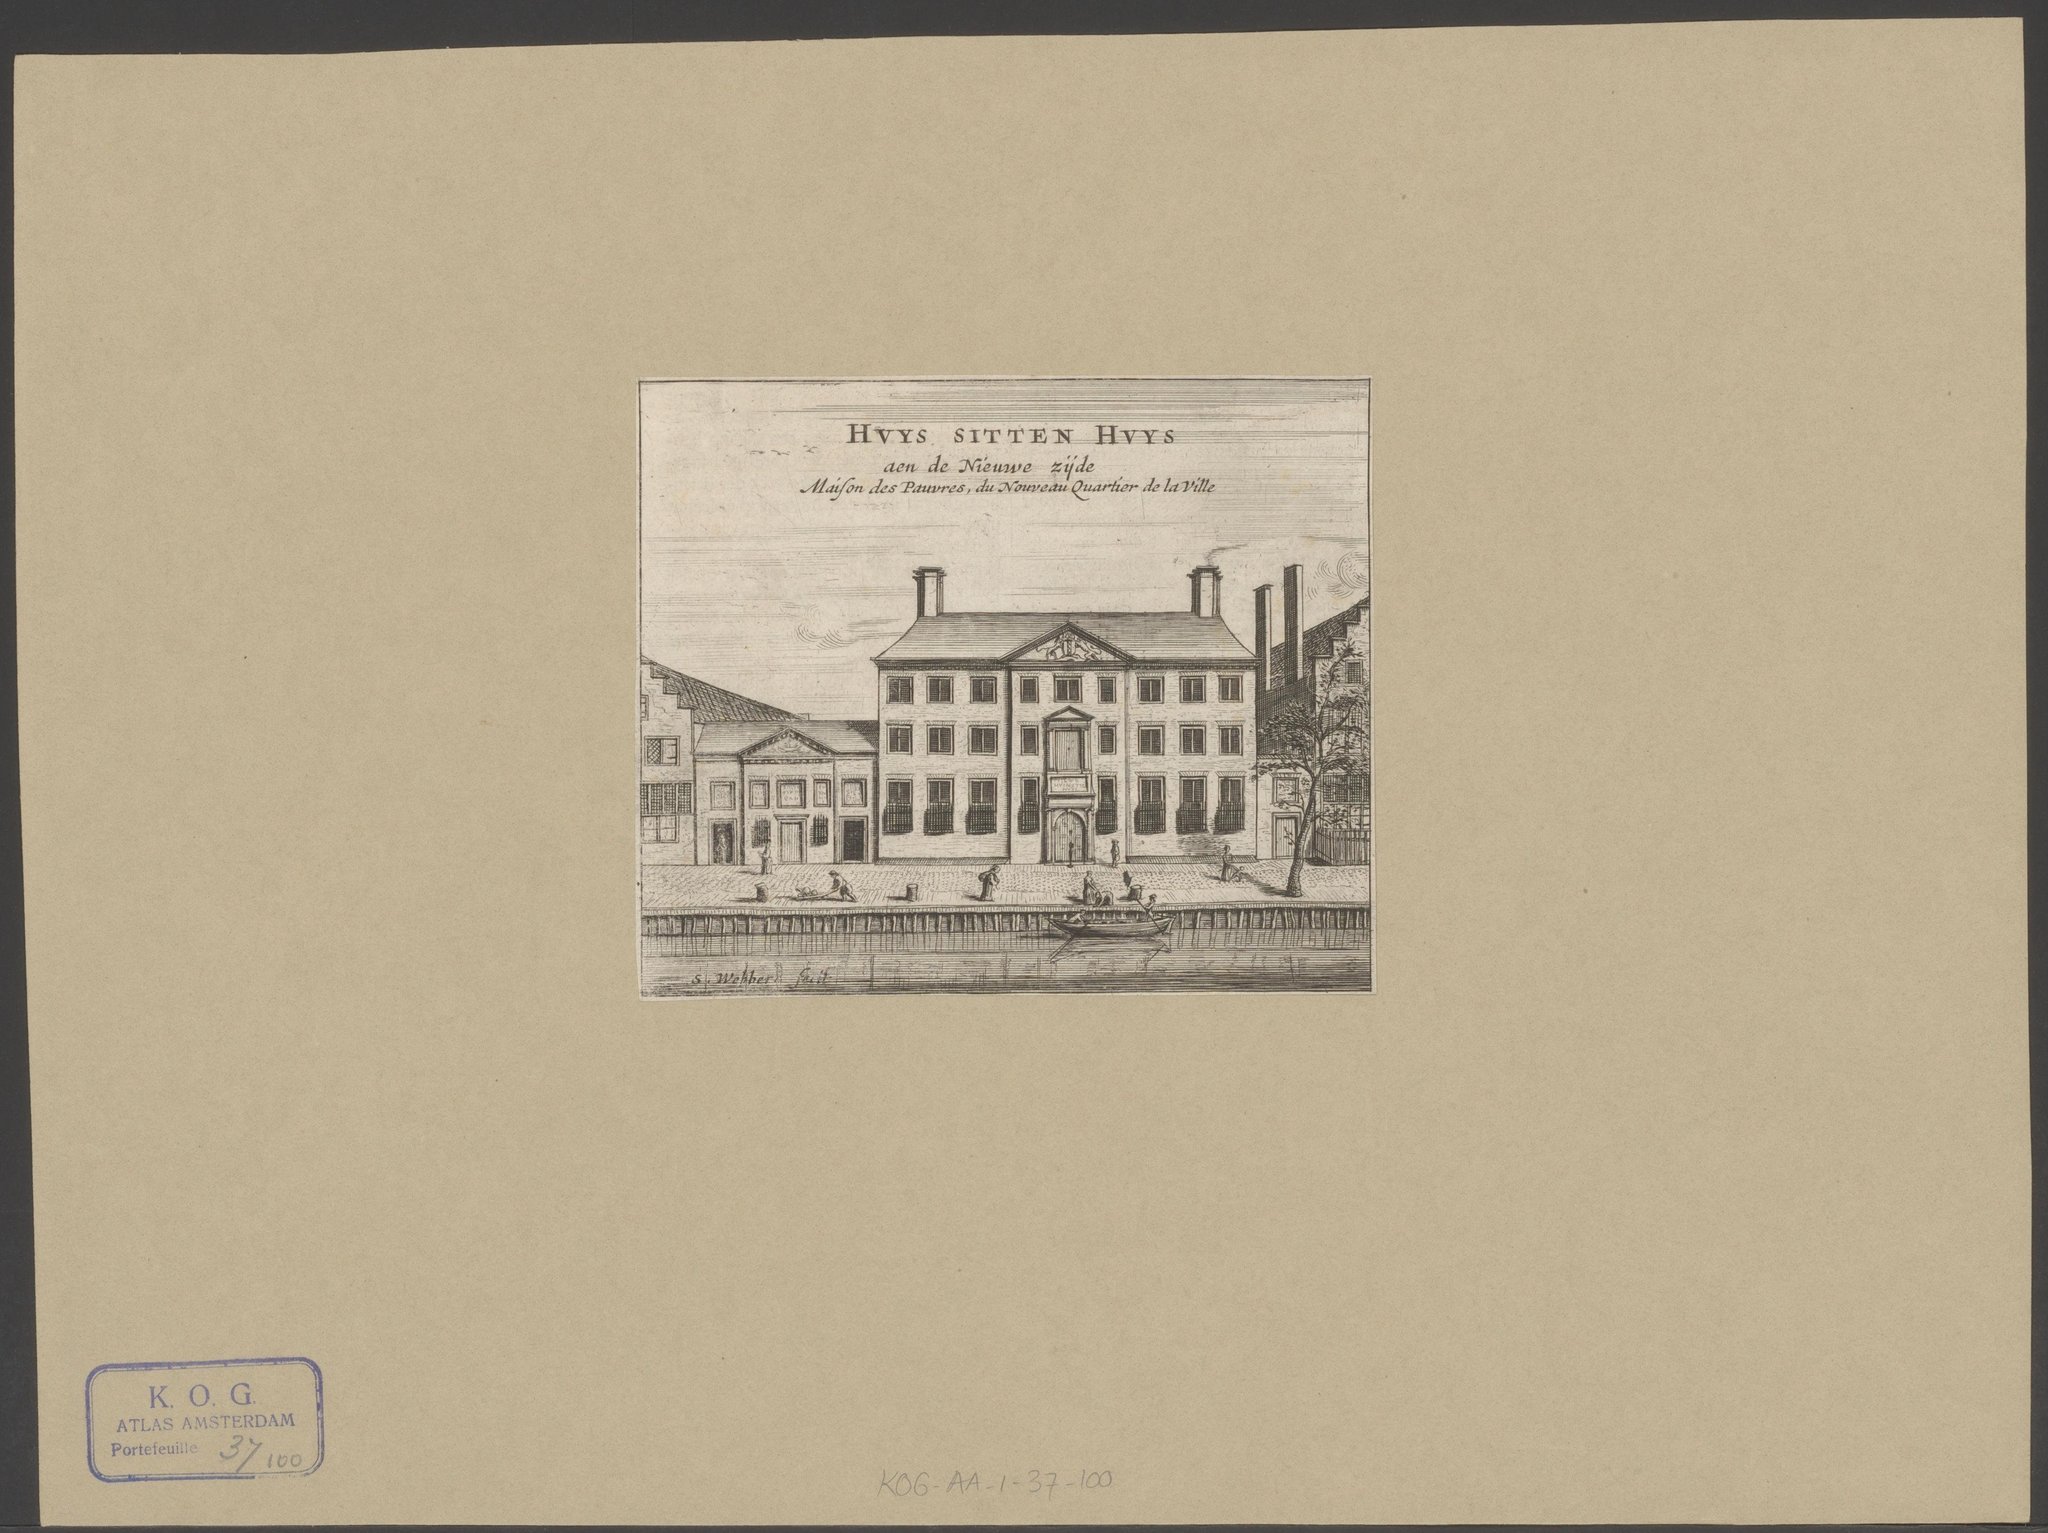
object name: book illustration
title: Gezicht op het Nieuwezijds Huiszittenhuis te Amsterdam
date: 1665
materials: paper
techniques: engraving, etching, letterpress printing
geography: amsterdam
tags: poorhouse, canals, waters (in city) (+ city(-scape) with figures, staffage)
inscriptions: collector's mark: Lugt 1641b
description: Onderwerpsrubriek binnen de Atlas Amsterdam: Armwezen en liefdadige instellingen: I. Stadsinrichtingen: Stedelijk Armenhuis - Huiszittenhuizen - Huiszitten Weduwenhof.